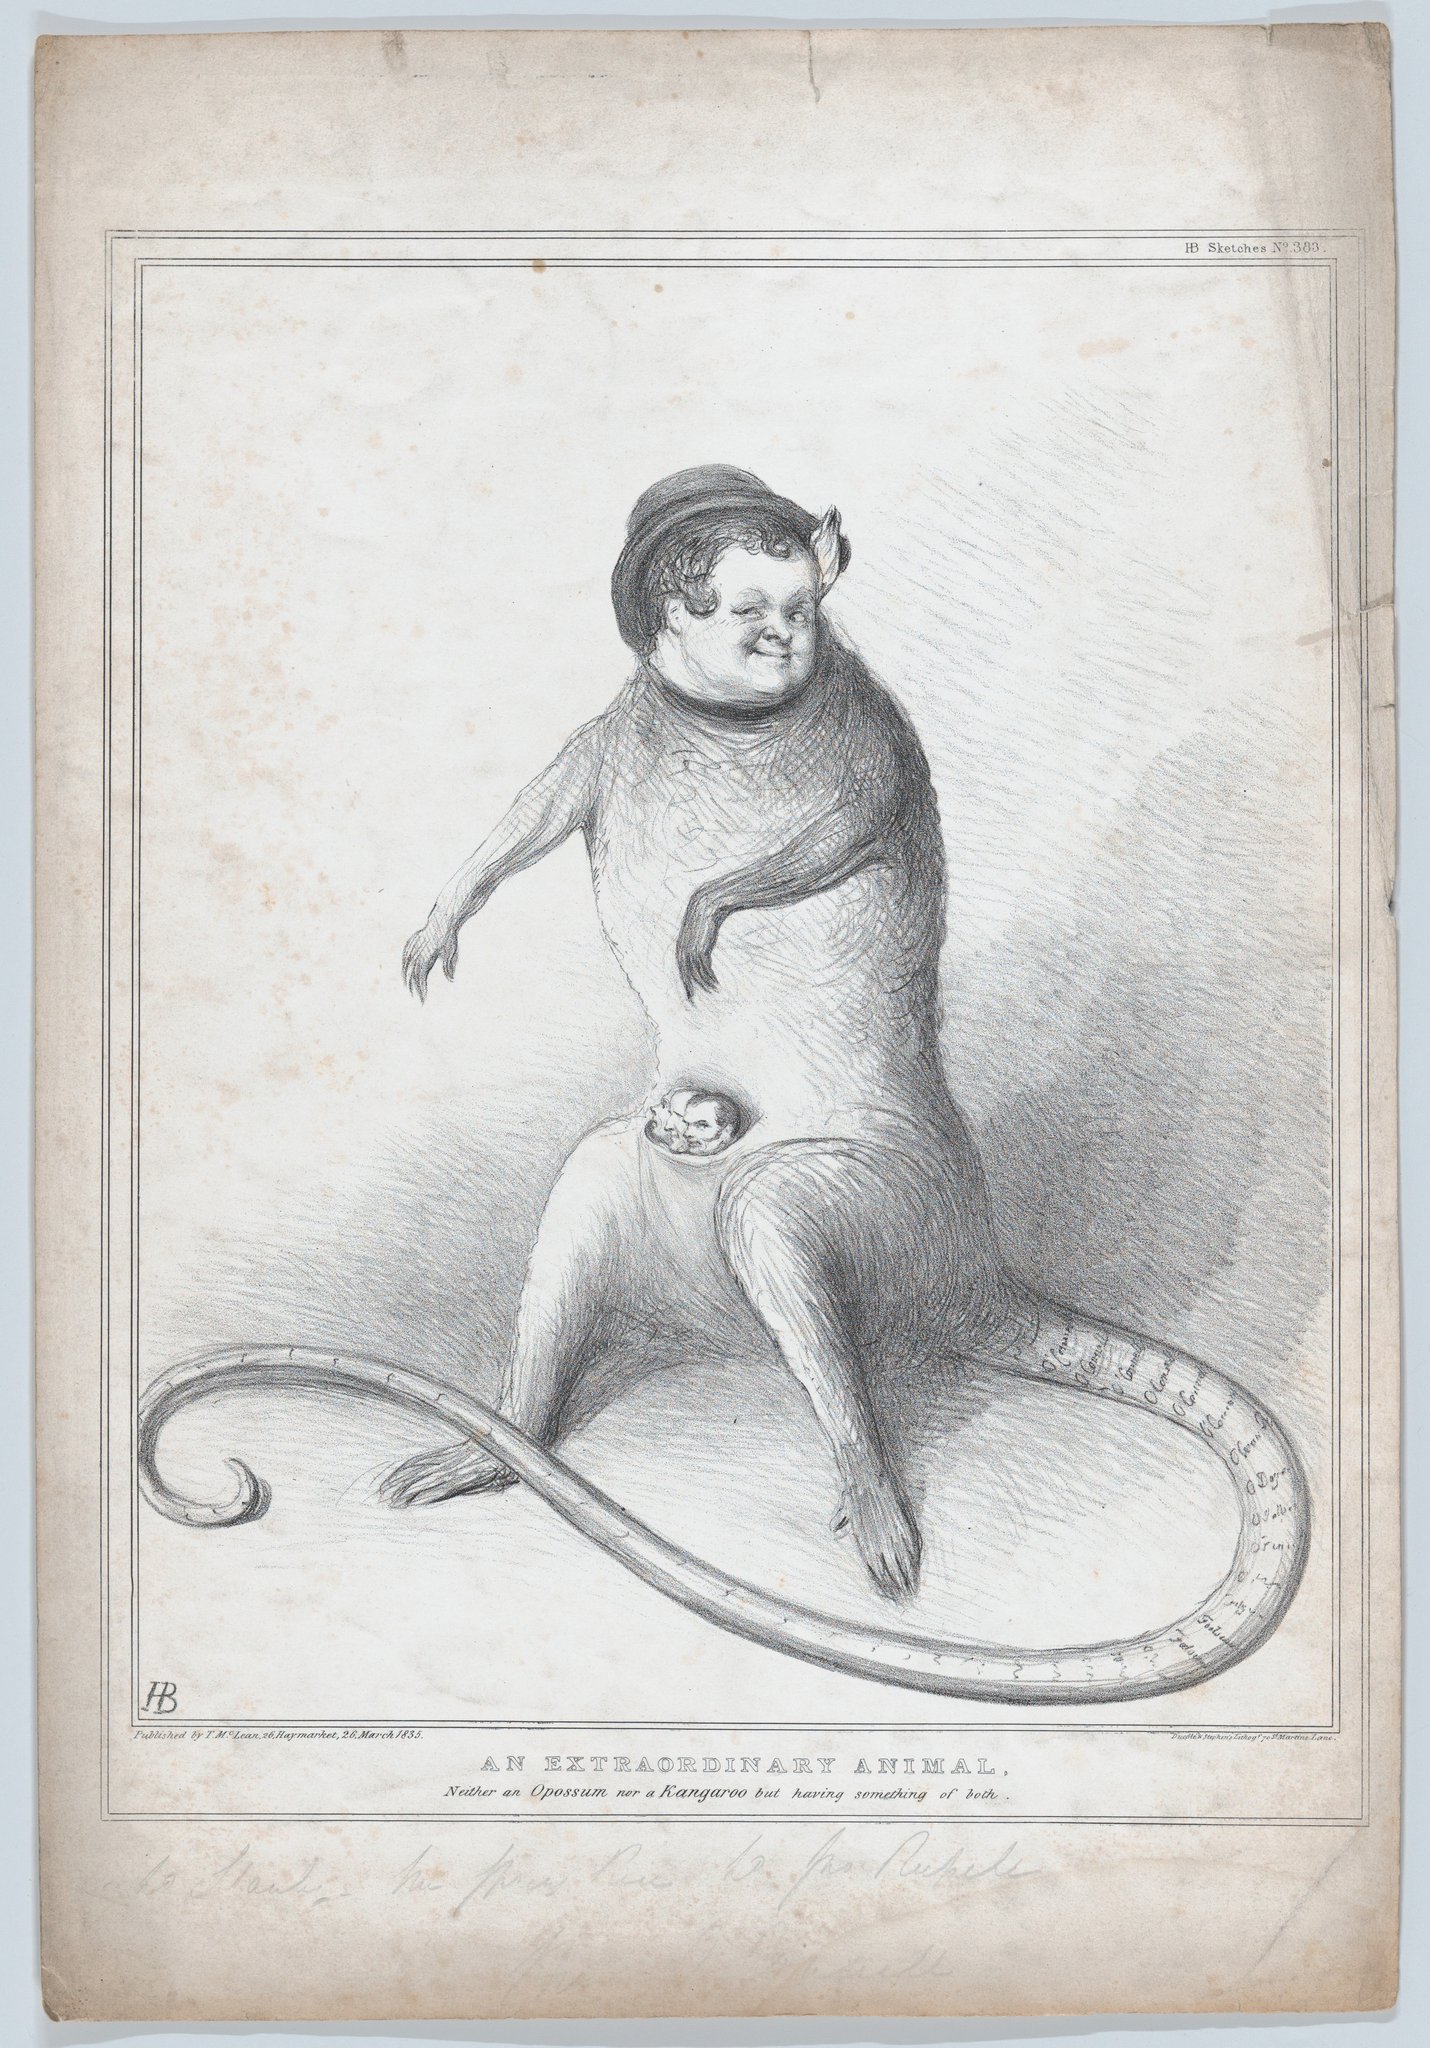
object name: print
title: An Extradordinary Animal. Neither an Opossum nor a Kangaroo but having something of both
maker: john doyle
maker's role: artist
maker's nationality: irish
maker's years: 1797-1868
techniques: lithograph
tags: animals,satire